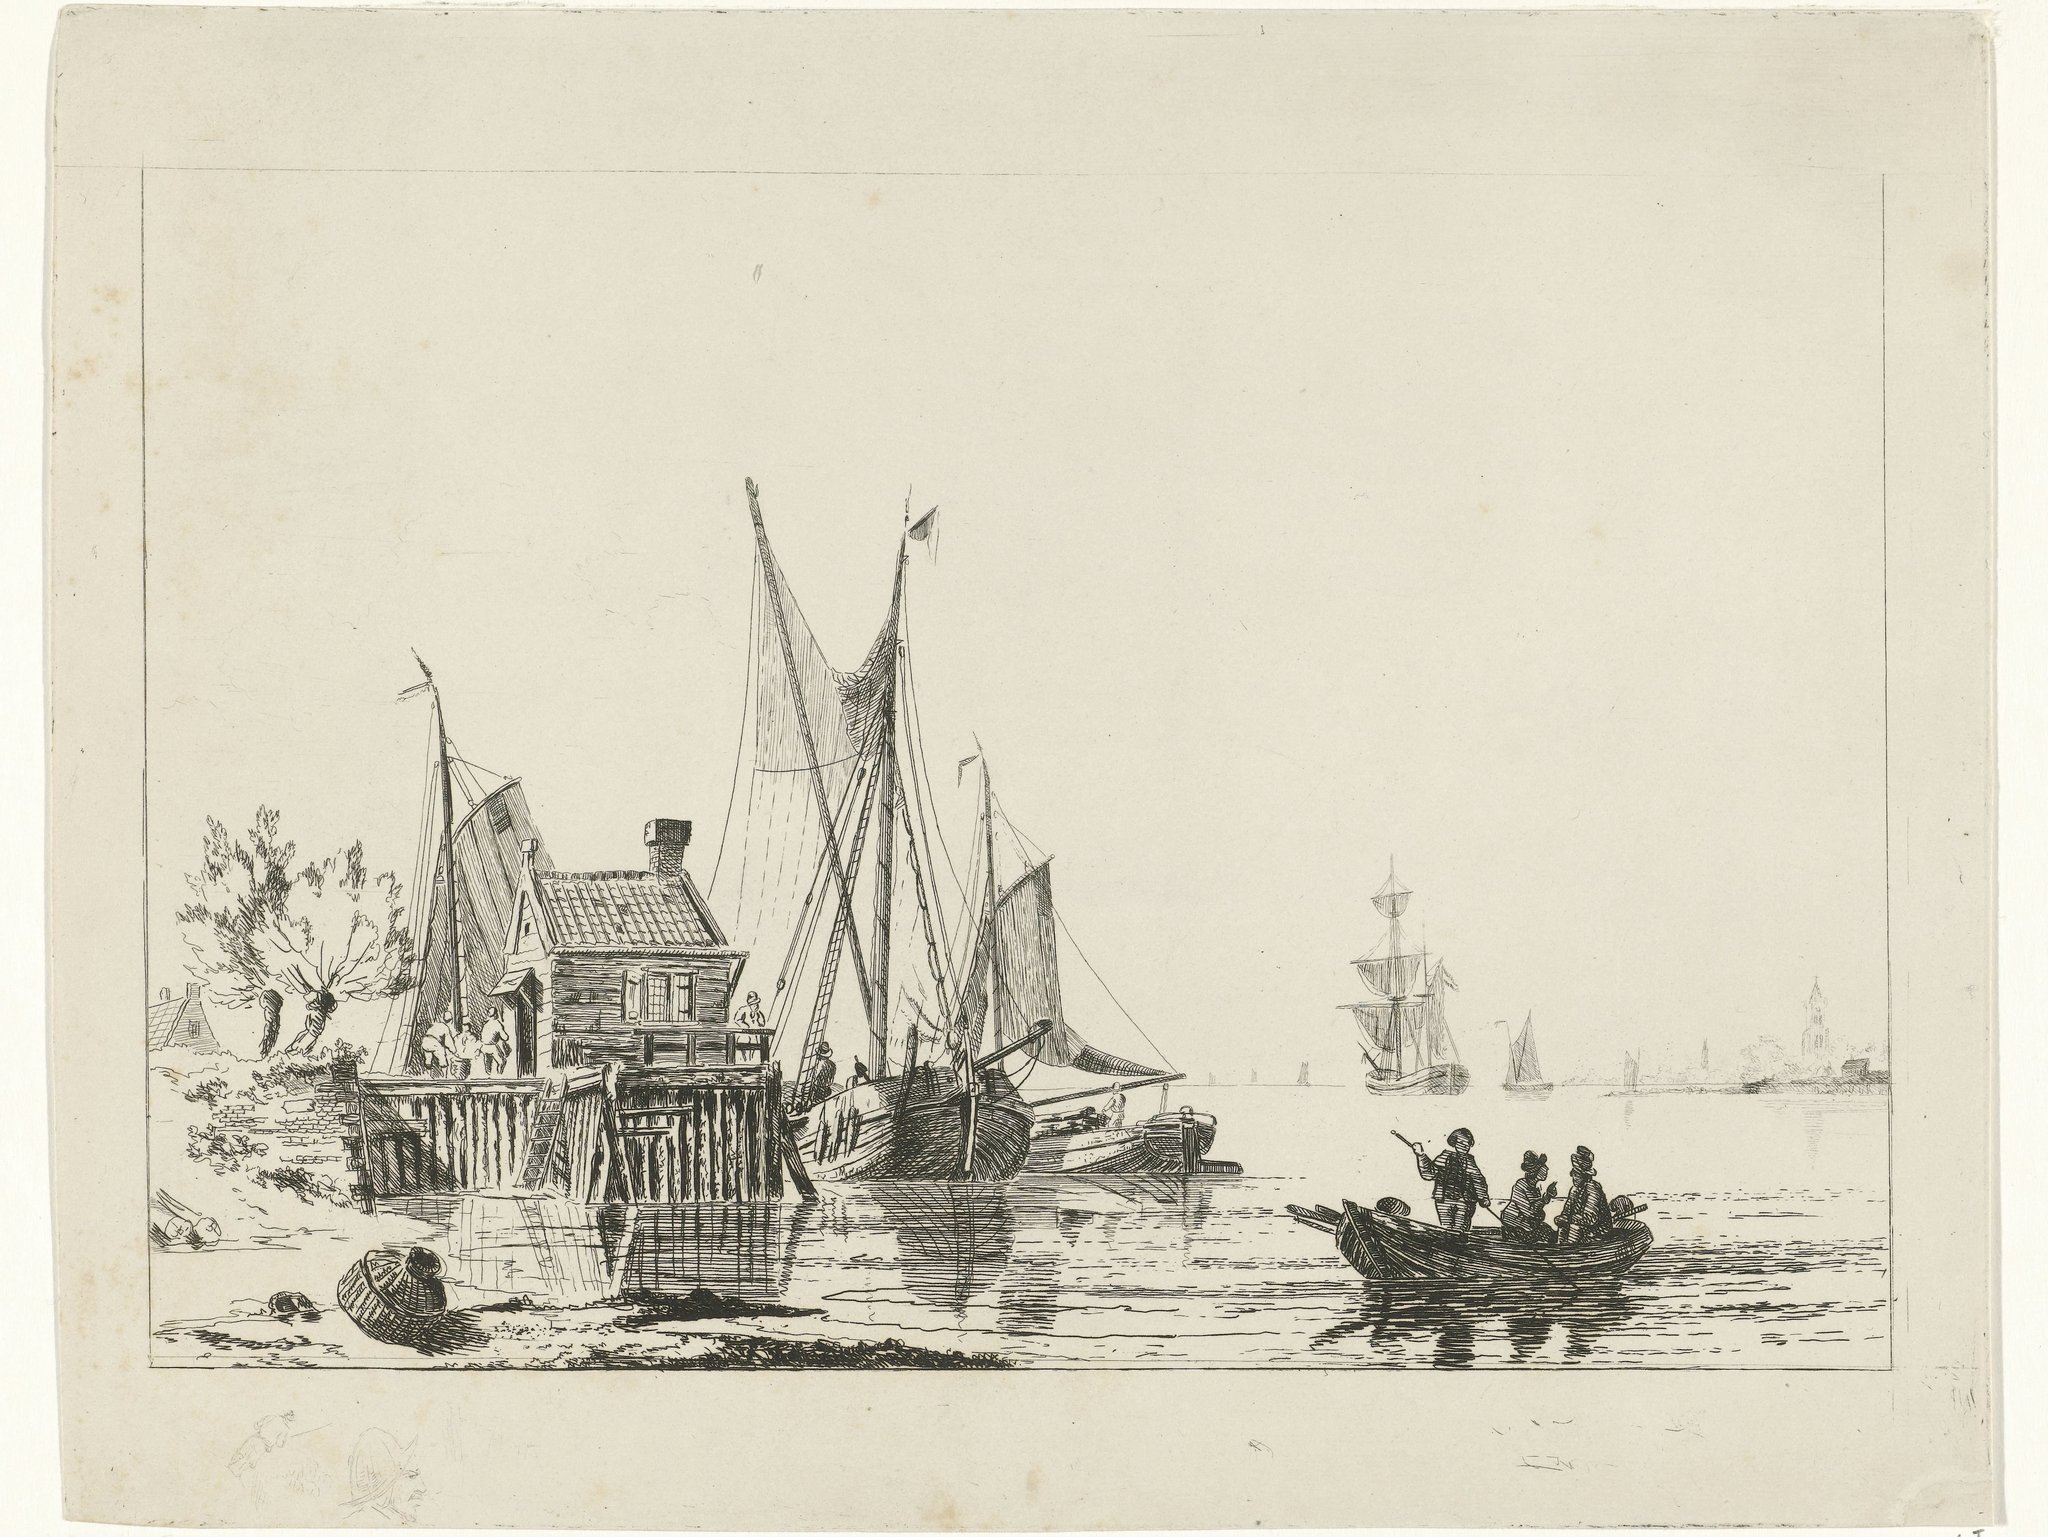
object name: print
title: Riviergezicht met aangemeerde zeilschepen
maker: willem gruyter jr.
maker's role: draughtsman, print maker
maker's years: 1817-1880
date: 1832-1880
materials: paper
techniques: etching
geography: amsterdam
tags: rowing-boat, canoe, etc., sailing-ship, sailing-boat (+ four persons or more ~ traffic and transport)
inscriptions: collector's mark: Lugt 2165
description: Houten huis bij een pier met aangemeerde zeilschepen en rechts op de voorgrond een roeiboot met drie mannen erin. Links onder de voorstelling twee schetsmatig geëtste figuren.